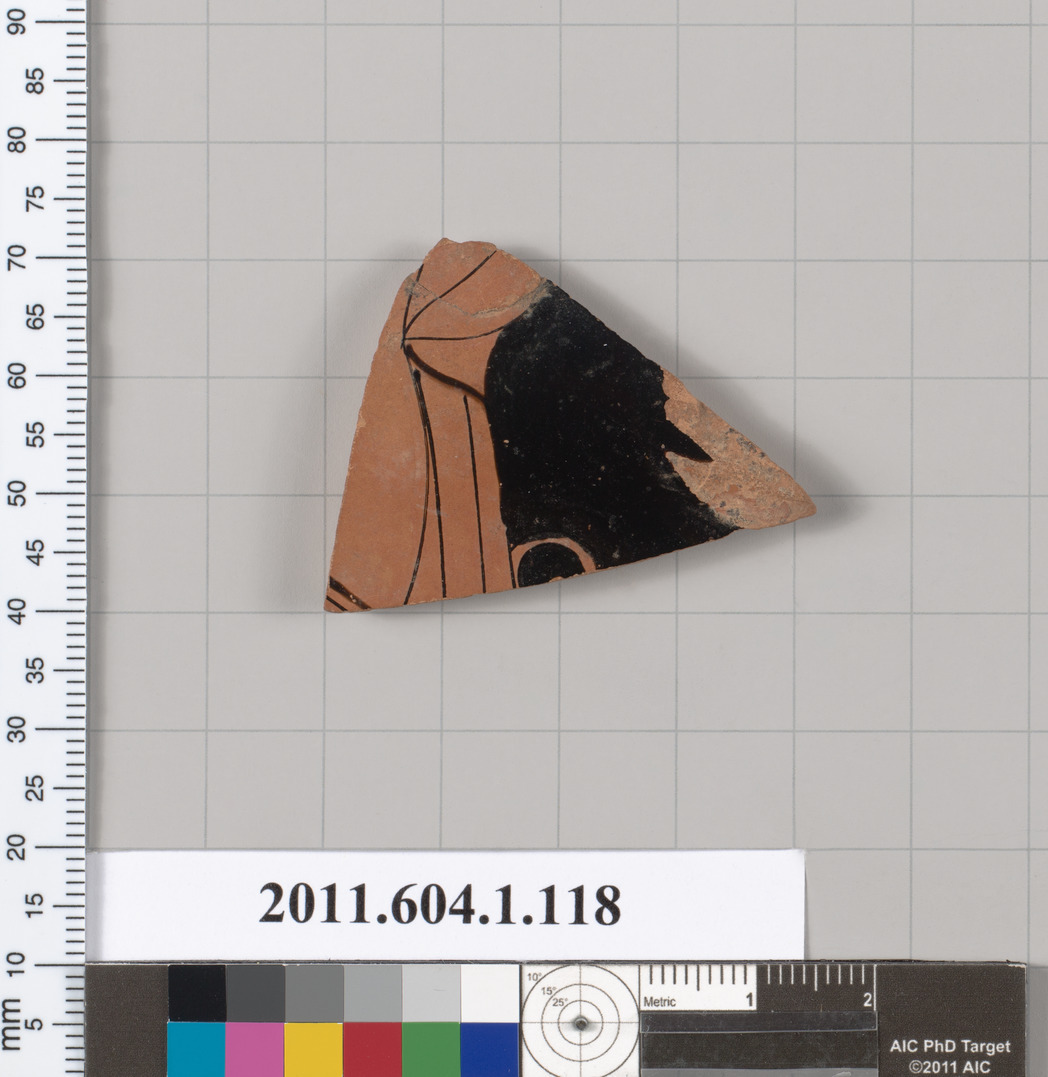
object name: kylix fragment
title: Terracotta fragment of a kylix (drinking cup)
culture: greek, attic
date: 470-450 BCE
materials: terracotta